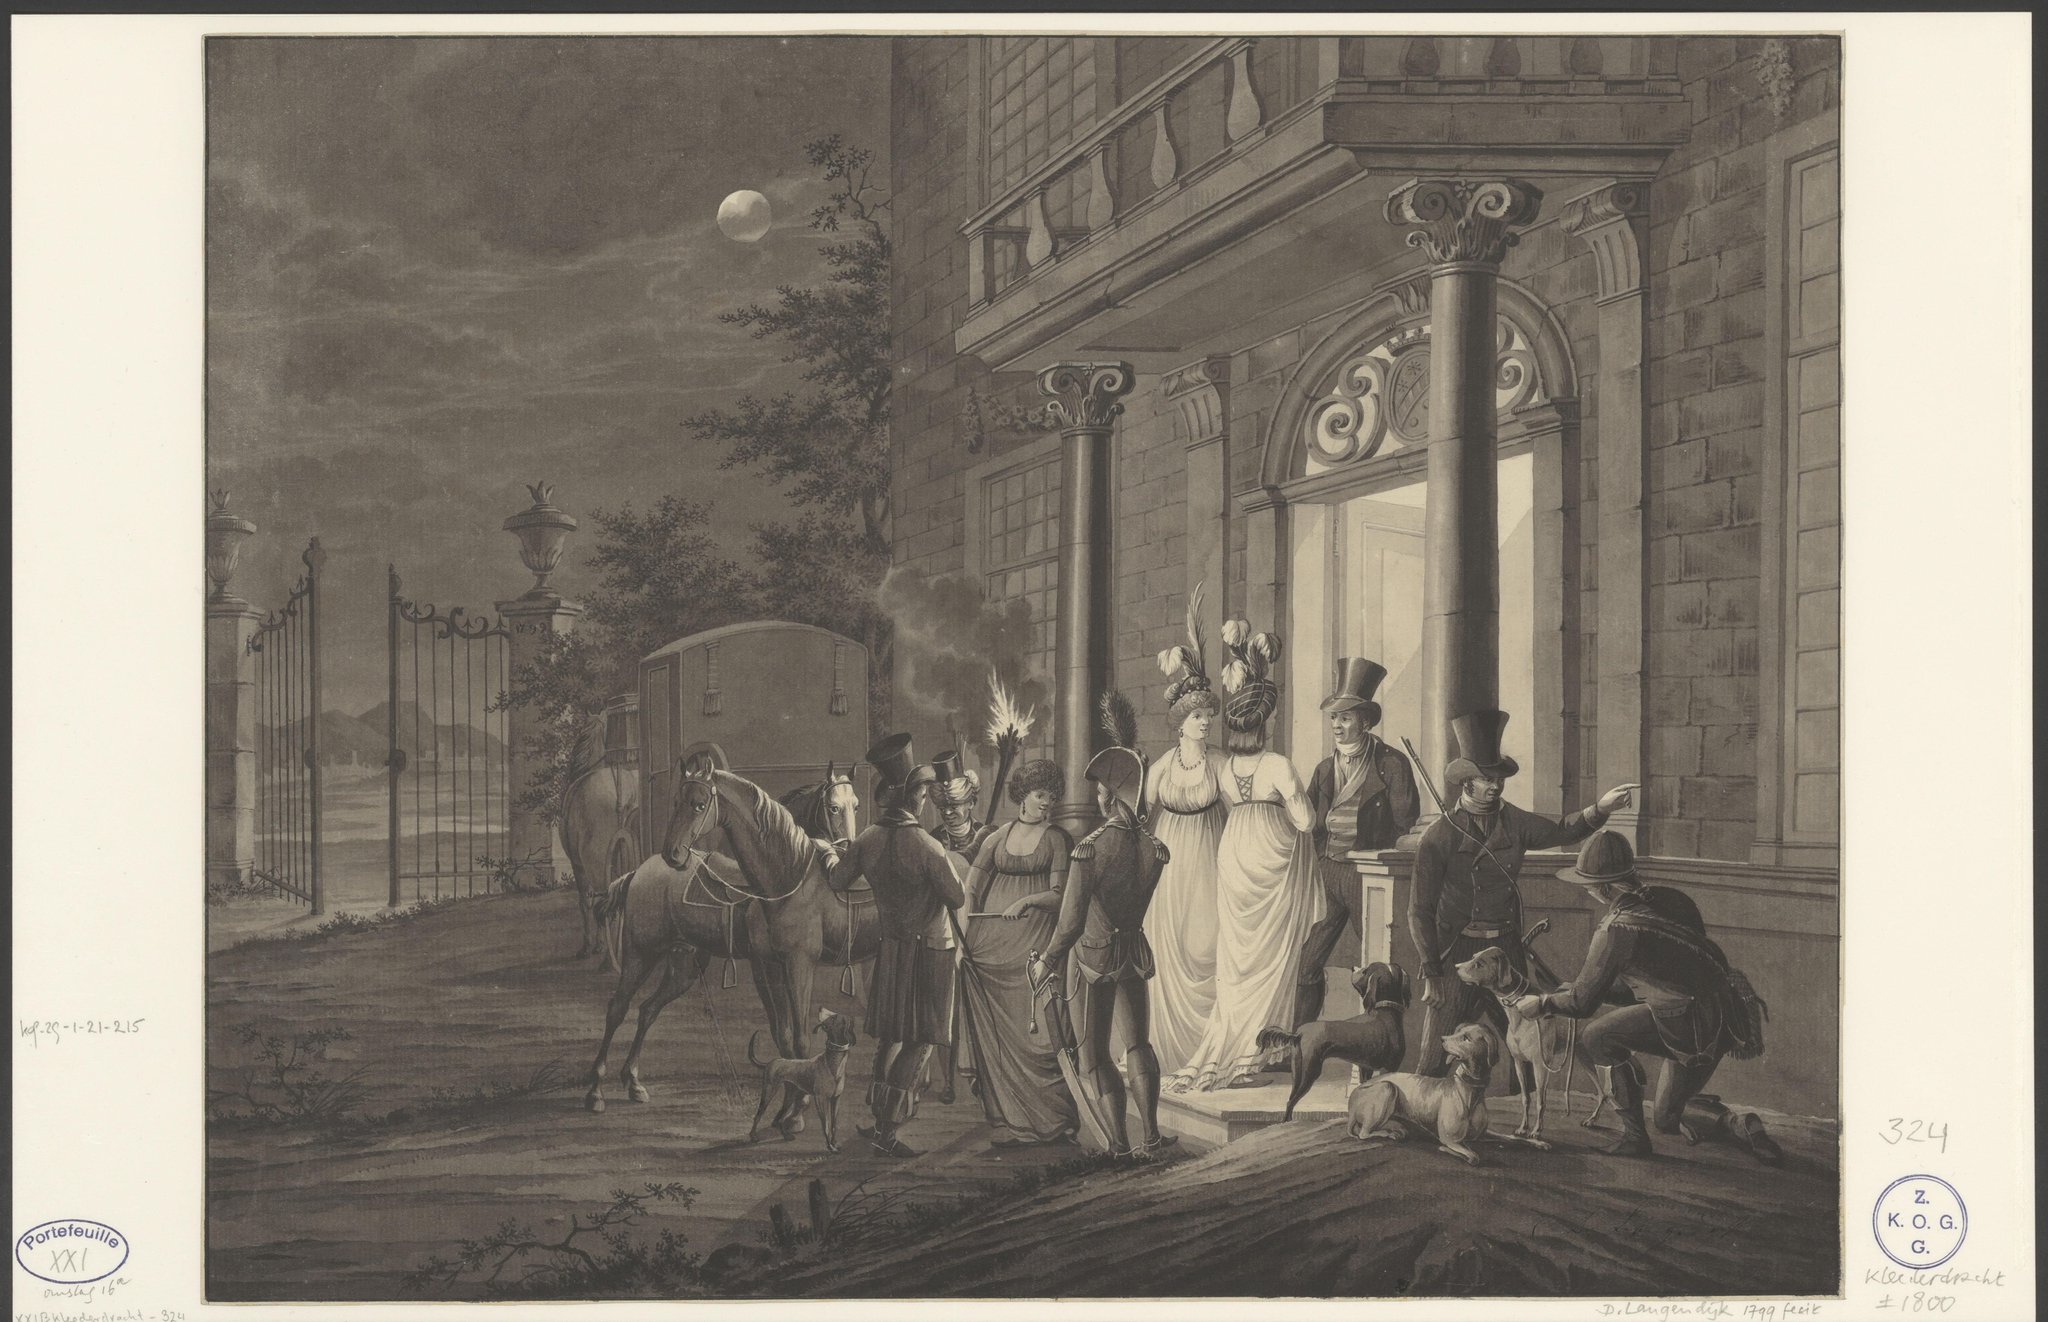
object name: drawing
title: Jachtgezelschap bij maanlicht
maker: dirk langendijk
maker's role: draughtsman, painter, print maker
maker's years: 1748-1805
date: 1799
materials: ink, paper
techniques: brush, pen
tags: group-portrait of hunters, hunting, chase, hunting dogs, hunter, hunter - cc - female hunter, huntress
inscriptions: stamp, collector's mark: Lugt 1641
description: Onderwerpsrubrieken binnen de Atlas Zeden en Gewoonten: Zeden en Gewoonten in Engeren Zin, De Kleeding, Kleederdrachten (tijdvakken), Het begin der 19de eeuw. Mannen en vrouwen.